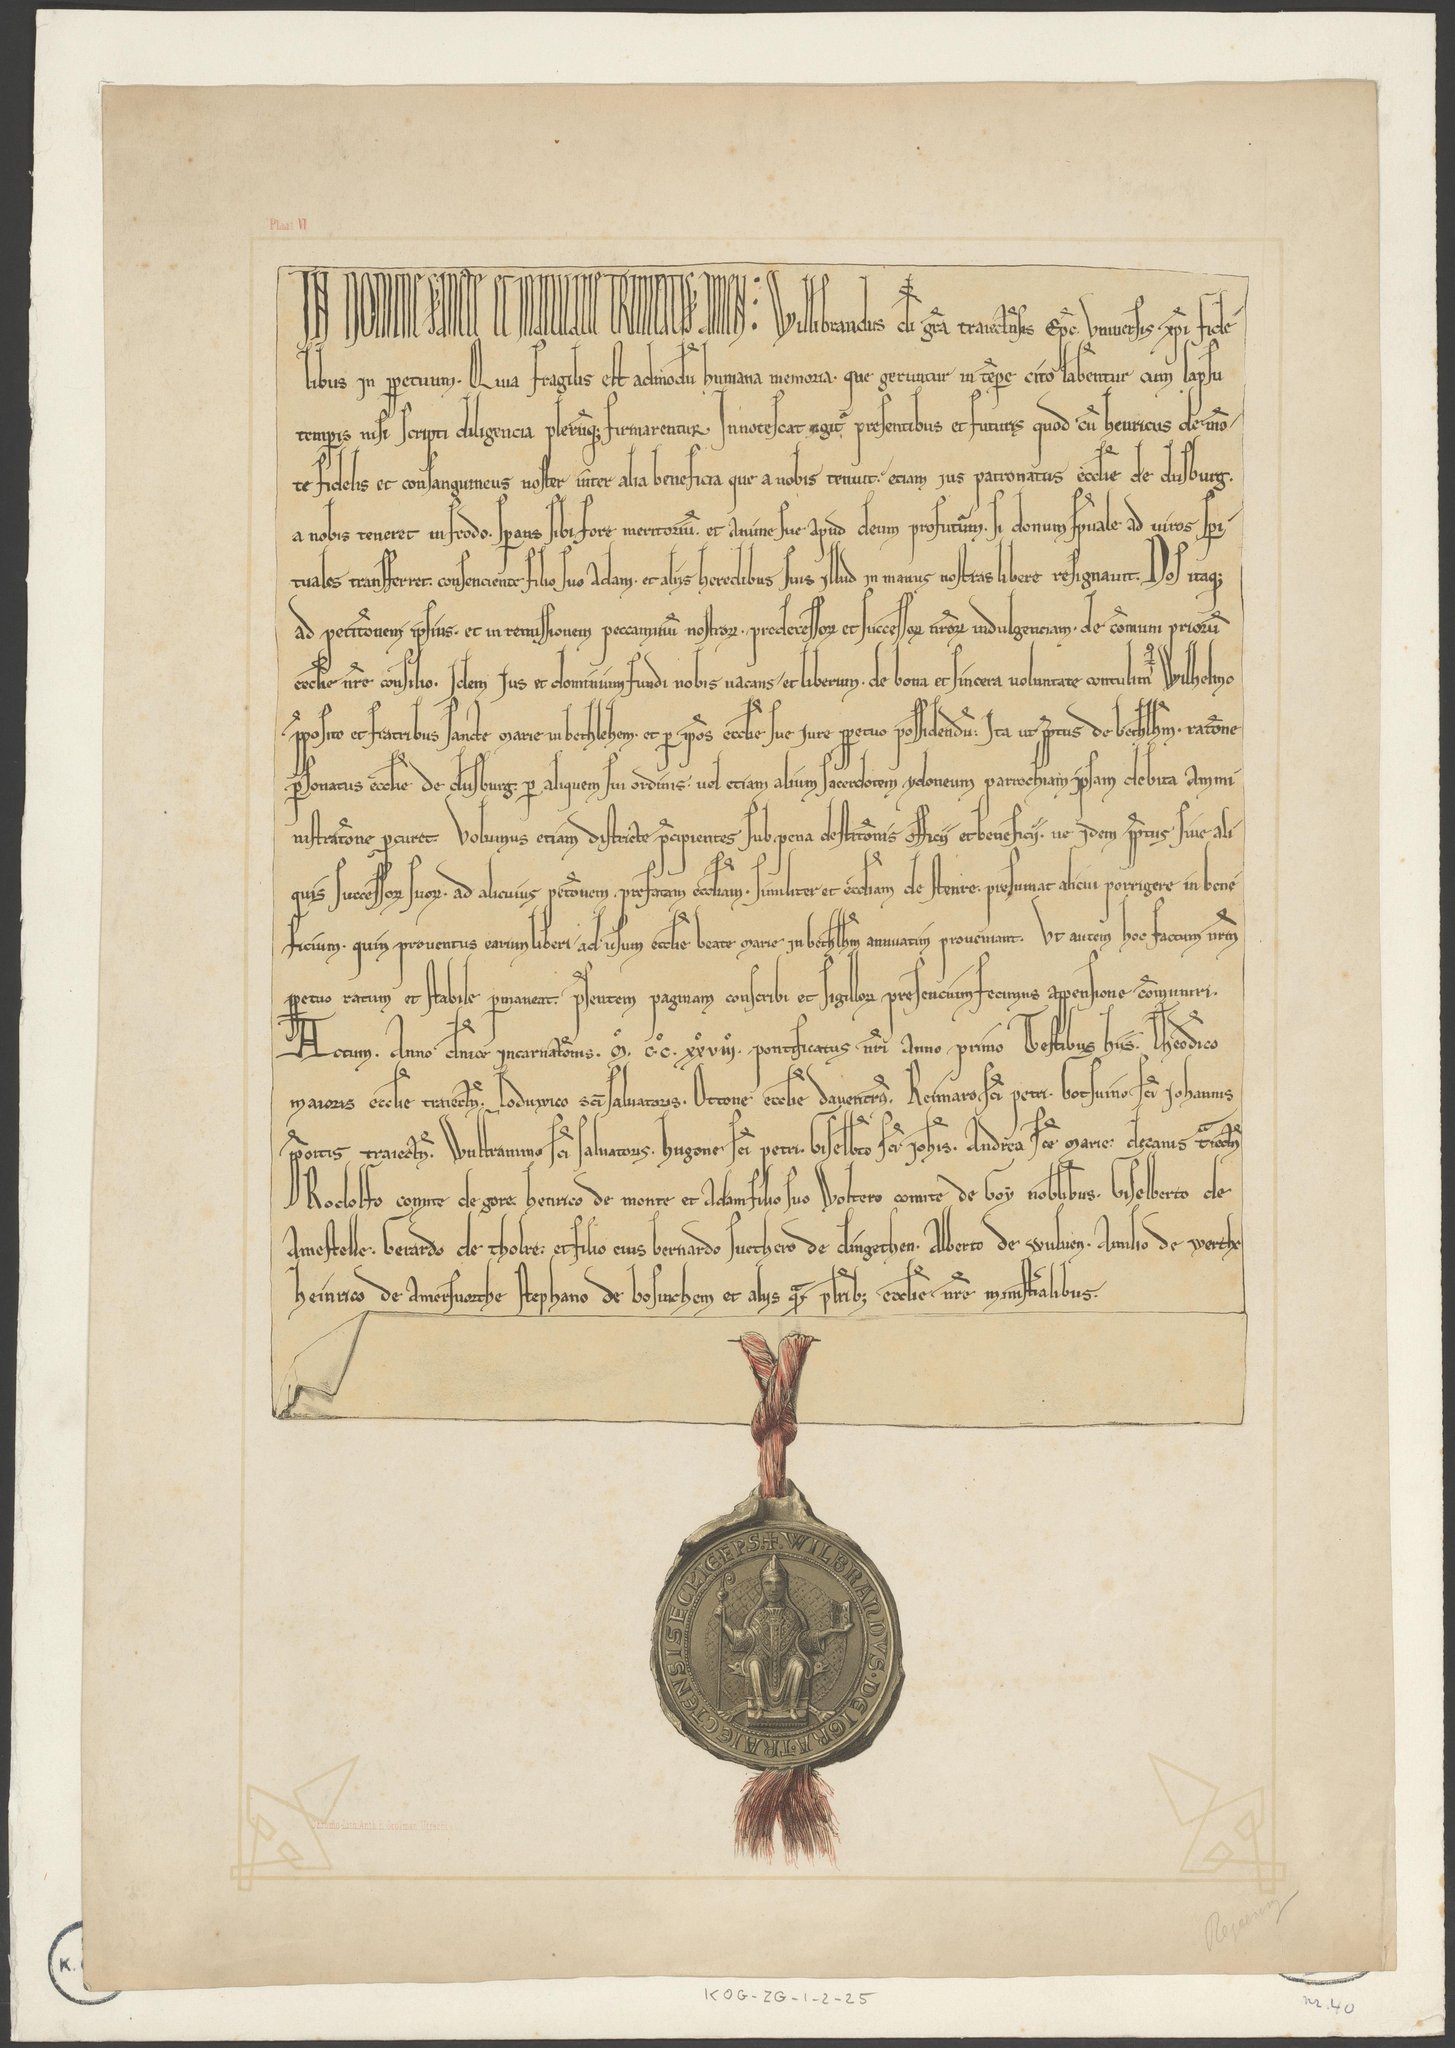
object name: print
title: Utrechtse charter met een zegel, 1228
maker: anthony grolman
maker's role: draughtsman, print maker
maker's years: 1843-1926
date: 1870-1920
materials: paper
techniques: chromolithography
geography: utrecht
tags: wilbrand van oldenburg, seal, stamp, handwriting, written text, seal (as symbol of the state, etc.), utrecht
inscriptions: collector's mark, collector's mark: Lugt 1641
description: Akte door Wilbrand van Oldenburg, bisschop van Utrecht, houdende overdracht van het patronaatsrecht van de kerk van Doesburg door Hendrik van den Berg, 1228. Charter met een zegel van Wilbrand van Oldenburg, bisschop van Utrecht 1227-1233. Linksboven: Plaat VI. Onderwerpsrubrieken binnen de Atlas Zeden en Gewoonten: Regeering, Zegels.